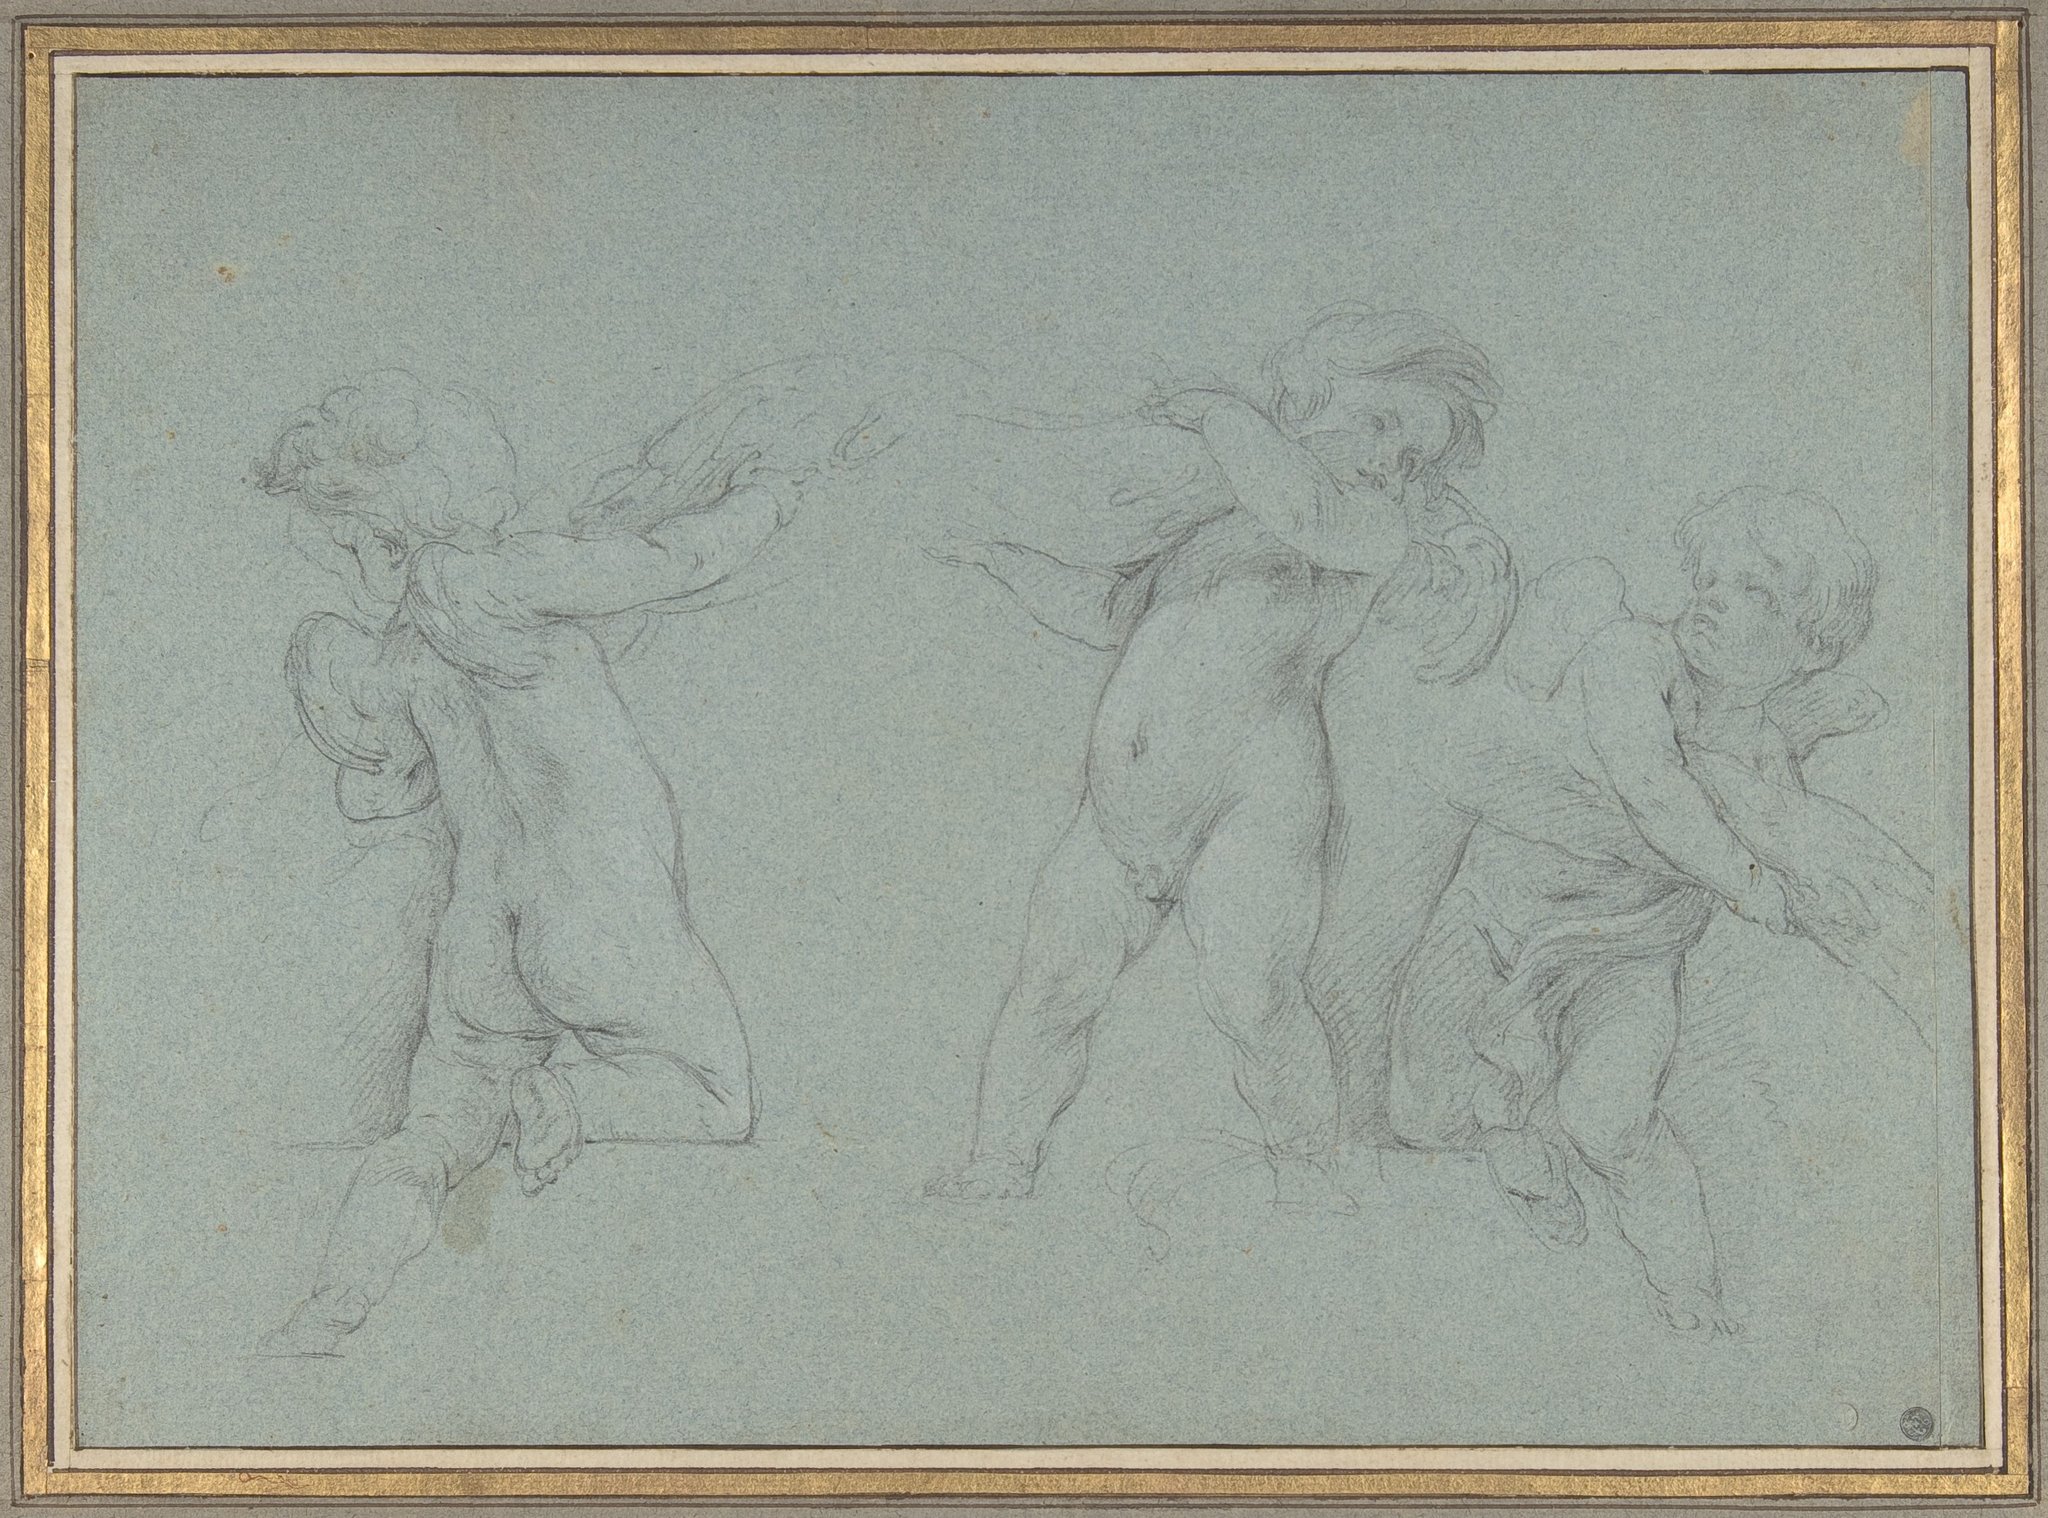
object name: drawing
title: Putti Supporting a Garland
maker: françois le moyne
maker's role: artist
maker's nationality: french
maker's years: 1688-1737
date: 1701-1733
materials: chalk, ink, paper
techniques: pen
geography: france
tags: putti